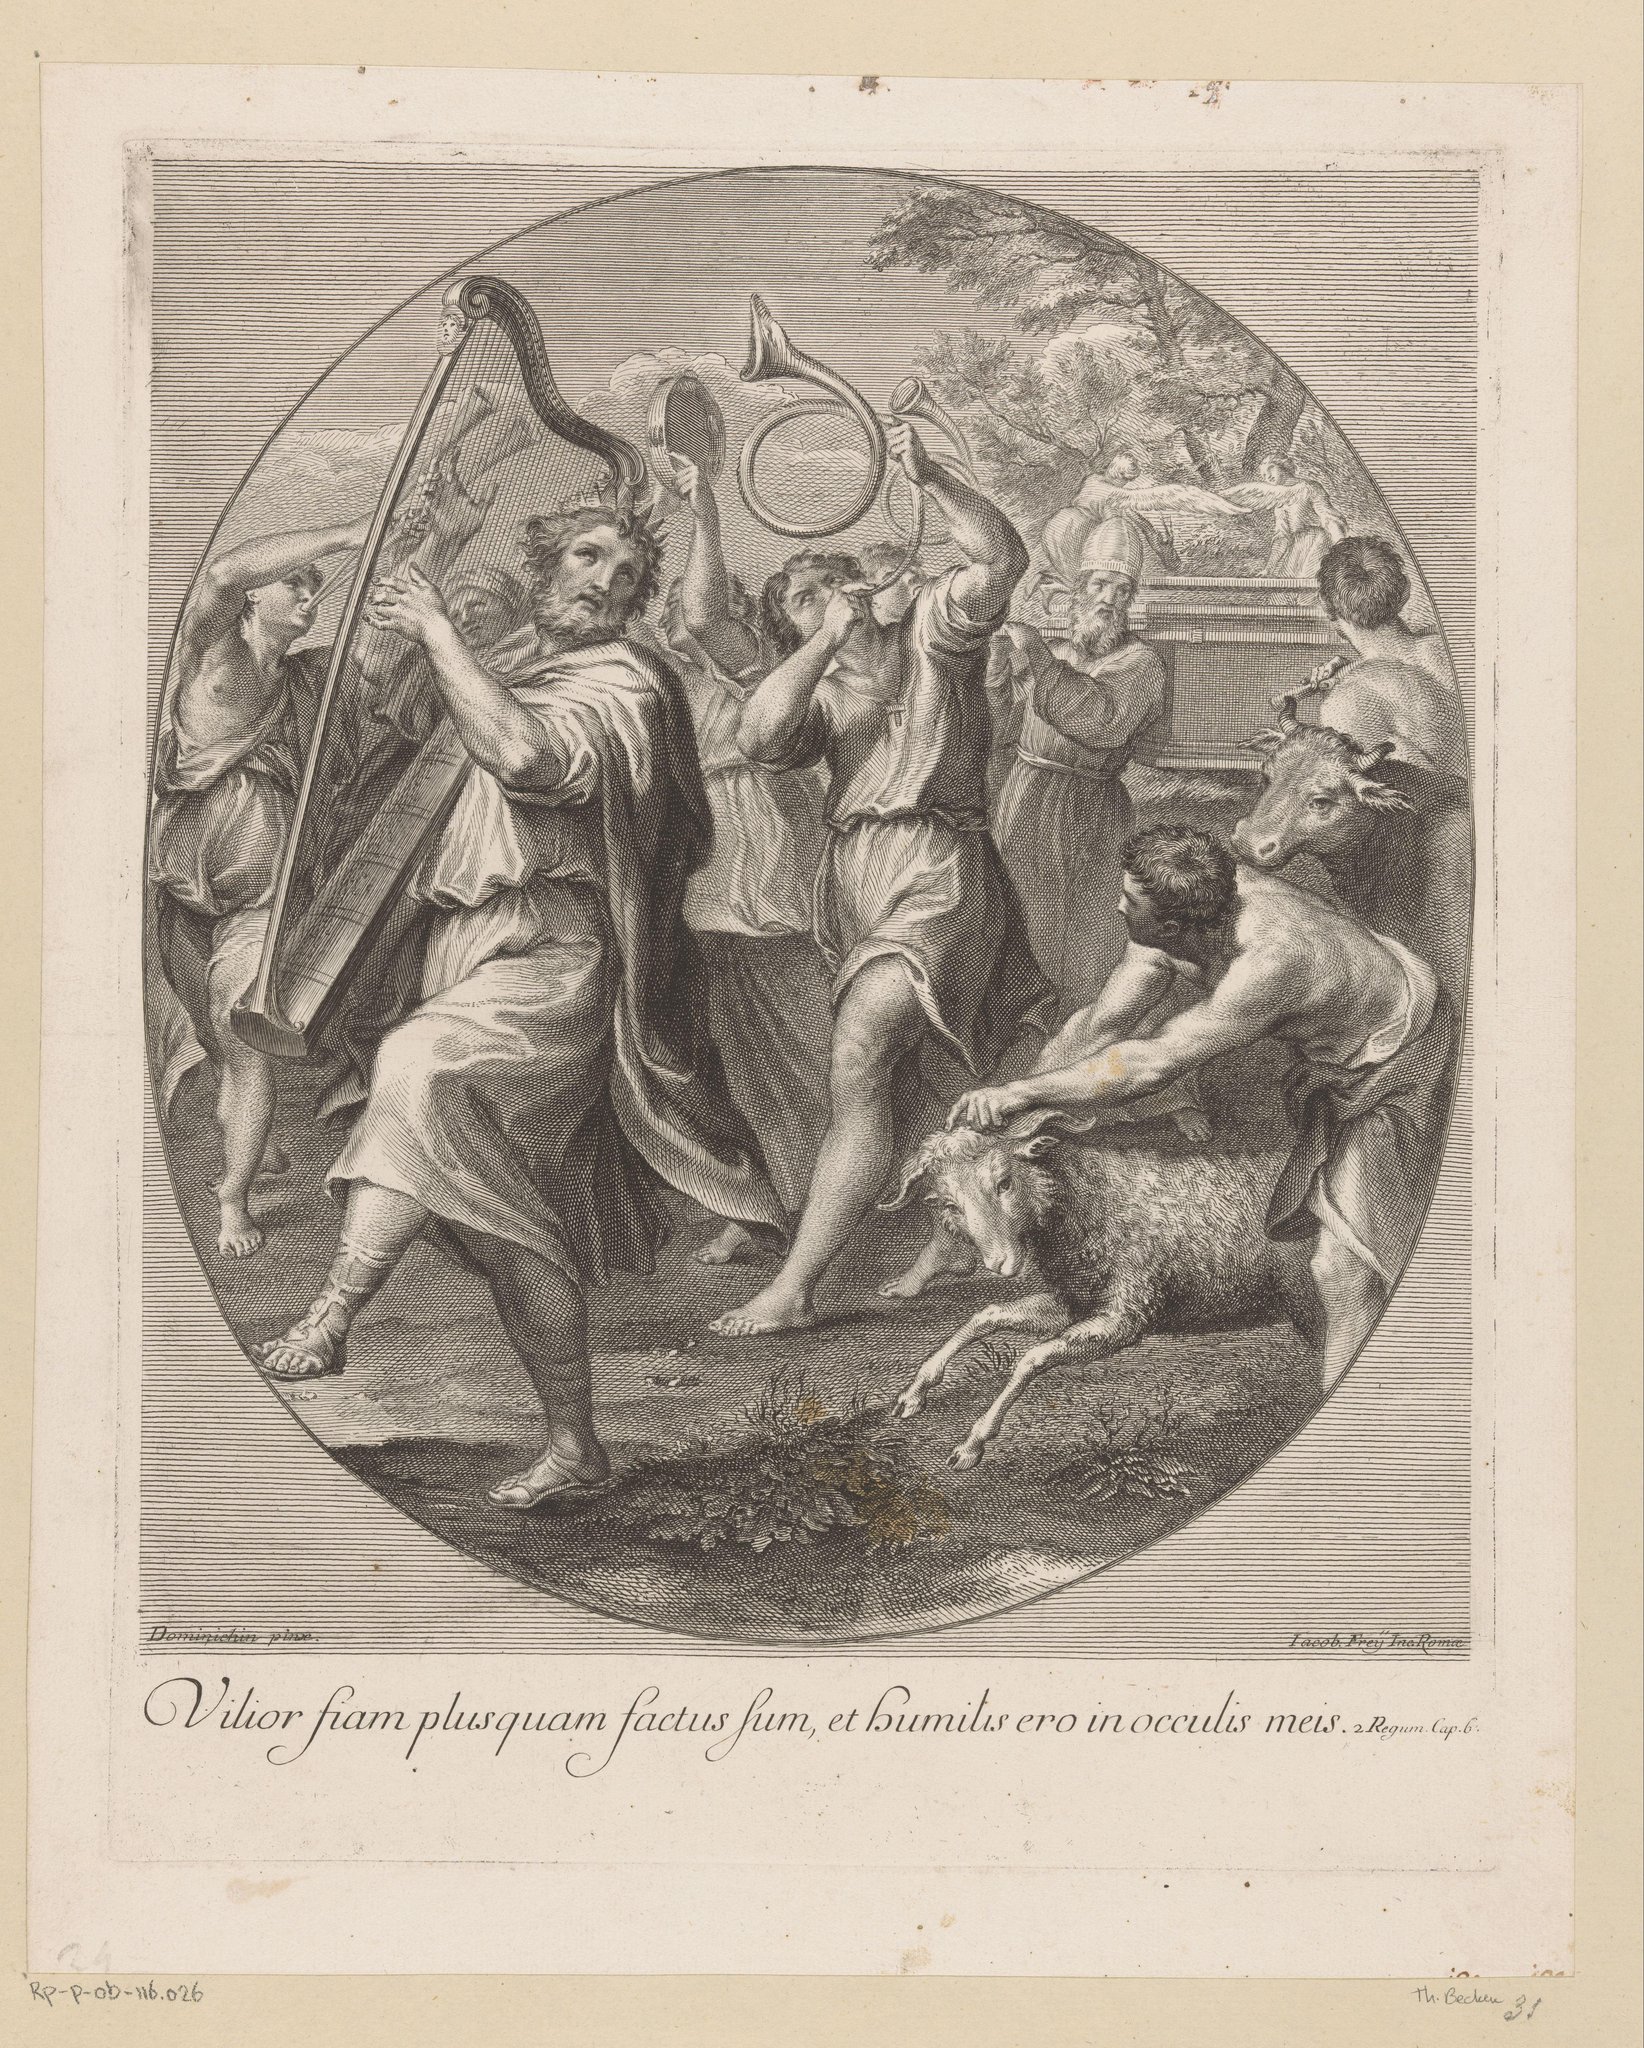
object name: print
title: David speelt op zijn harp en danst voor de Ark van het Verbond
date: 1718-1719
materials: paper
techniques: engraving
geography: rome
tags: the ark is placed on a cart driven by the sons of abinadab; david and the people dance and make music before the ark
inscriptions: collector's mark: Lugt 240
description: Naar één van de vier tondo's door Domenichino in de San Silvestro al Quirinale in Rome.